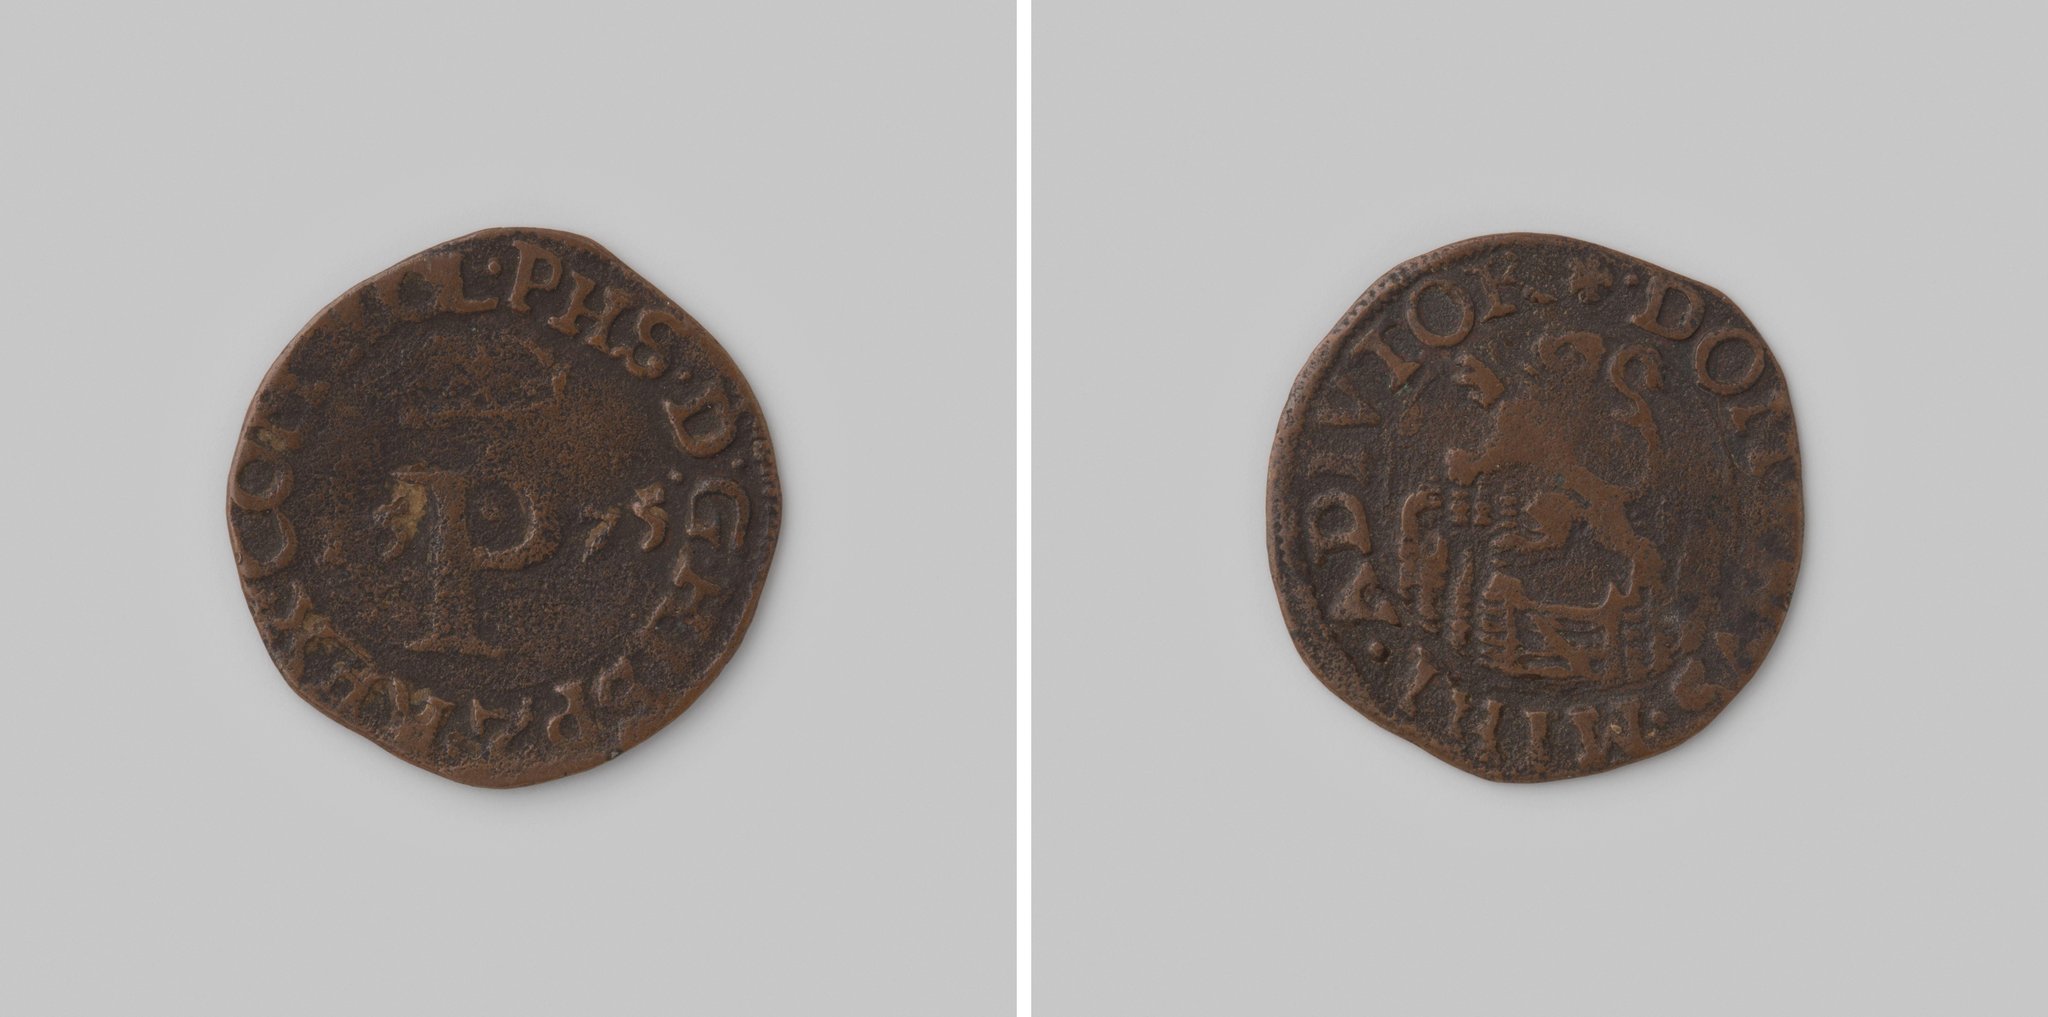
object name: penny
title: Hollandse penning op naam van Philips II, 1575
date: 1575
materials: copper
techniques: striking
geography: dordrecht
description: Koperen munt. Voorzijde: tussen jaartal letter P, waarboven krooon. In omschrift naam van Philips II. Keerzijde: Staande leeuw naar links binnen omheining.